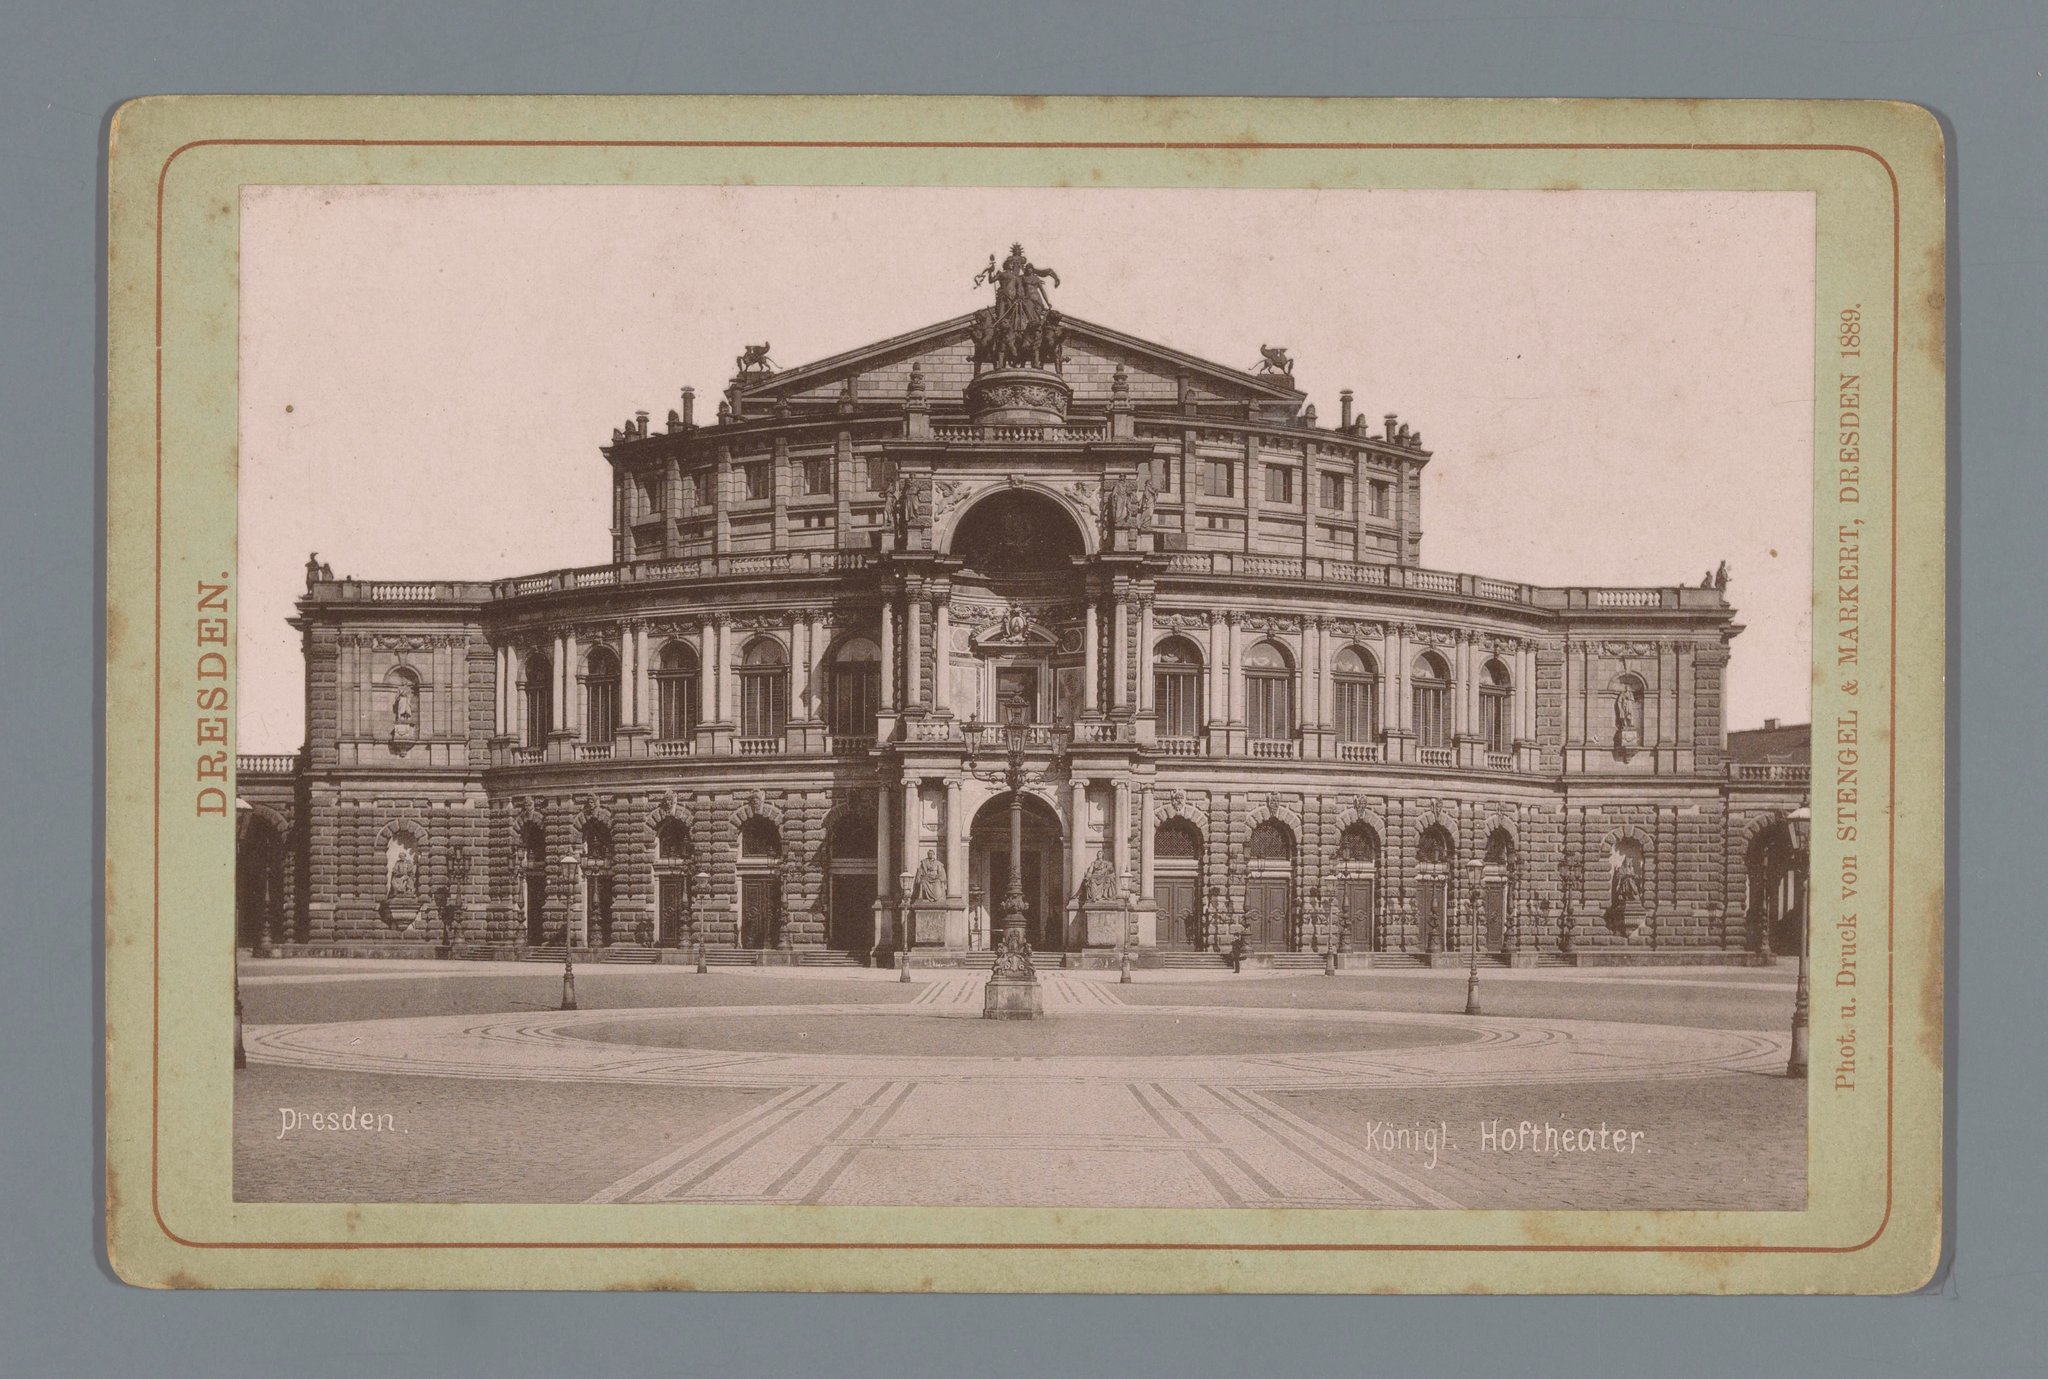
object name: photomechanical print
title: Dresden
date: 1889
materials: cardboard, paper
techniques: photograph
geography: dresden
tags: theatre (building)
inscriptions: date